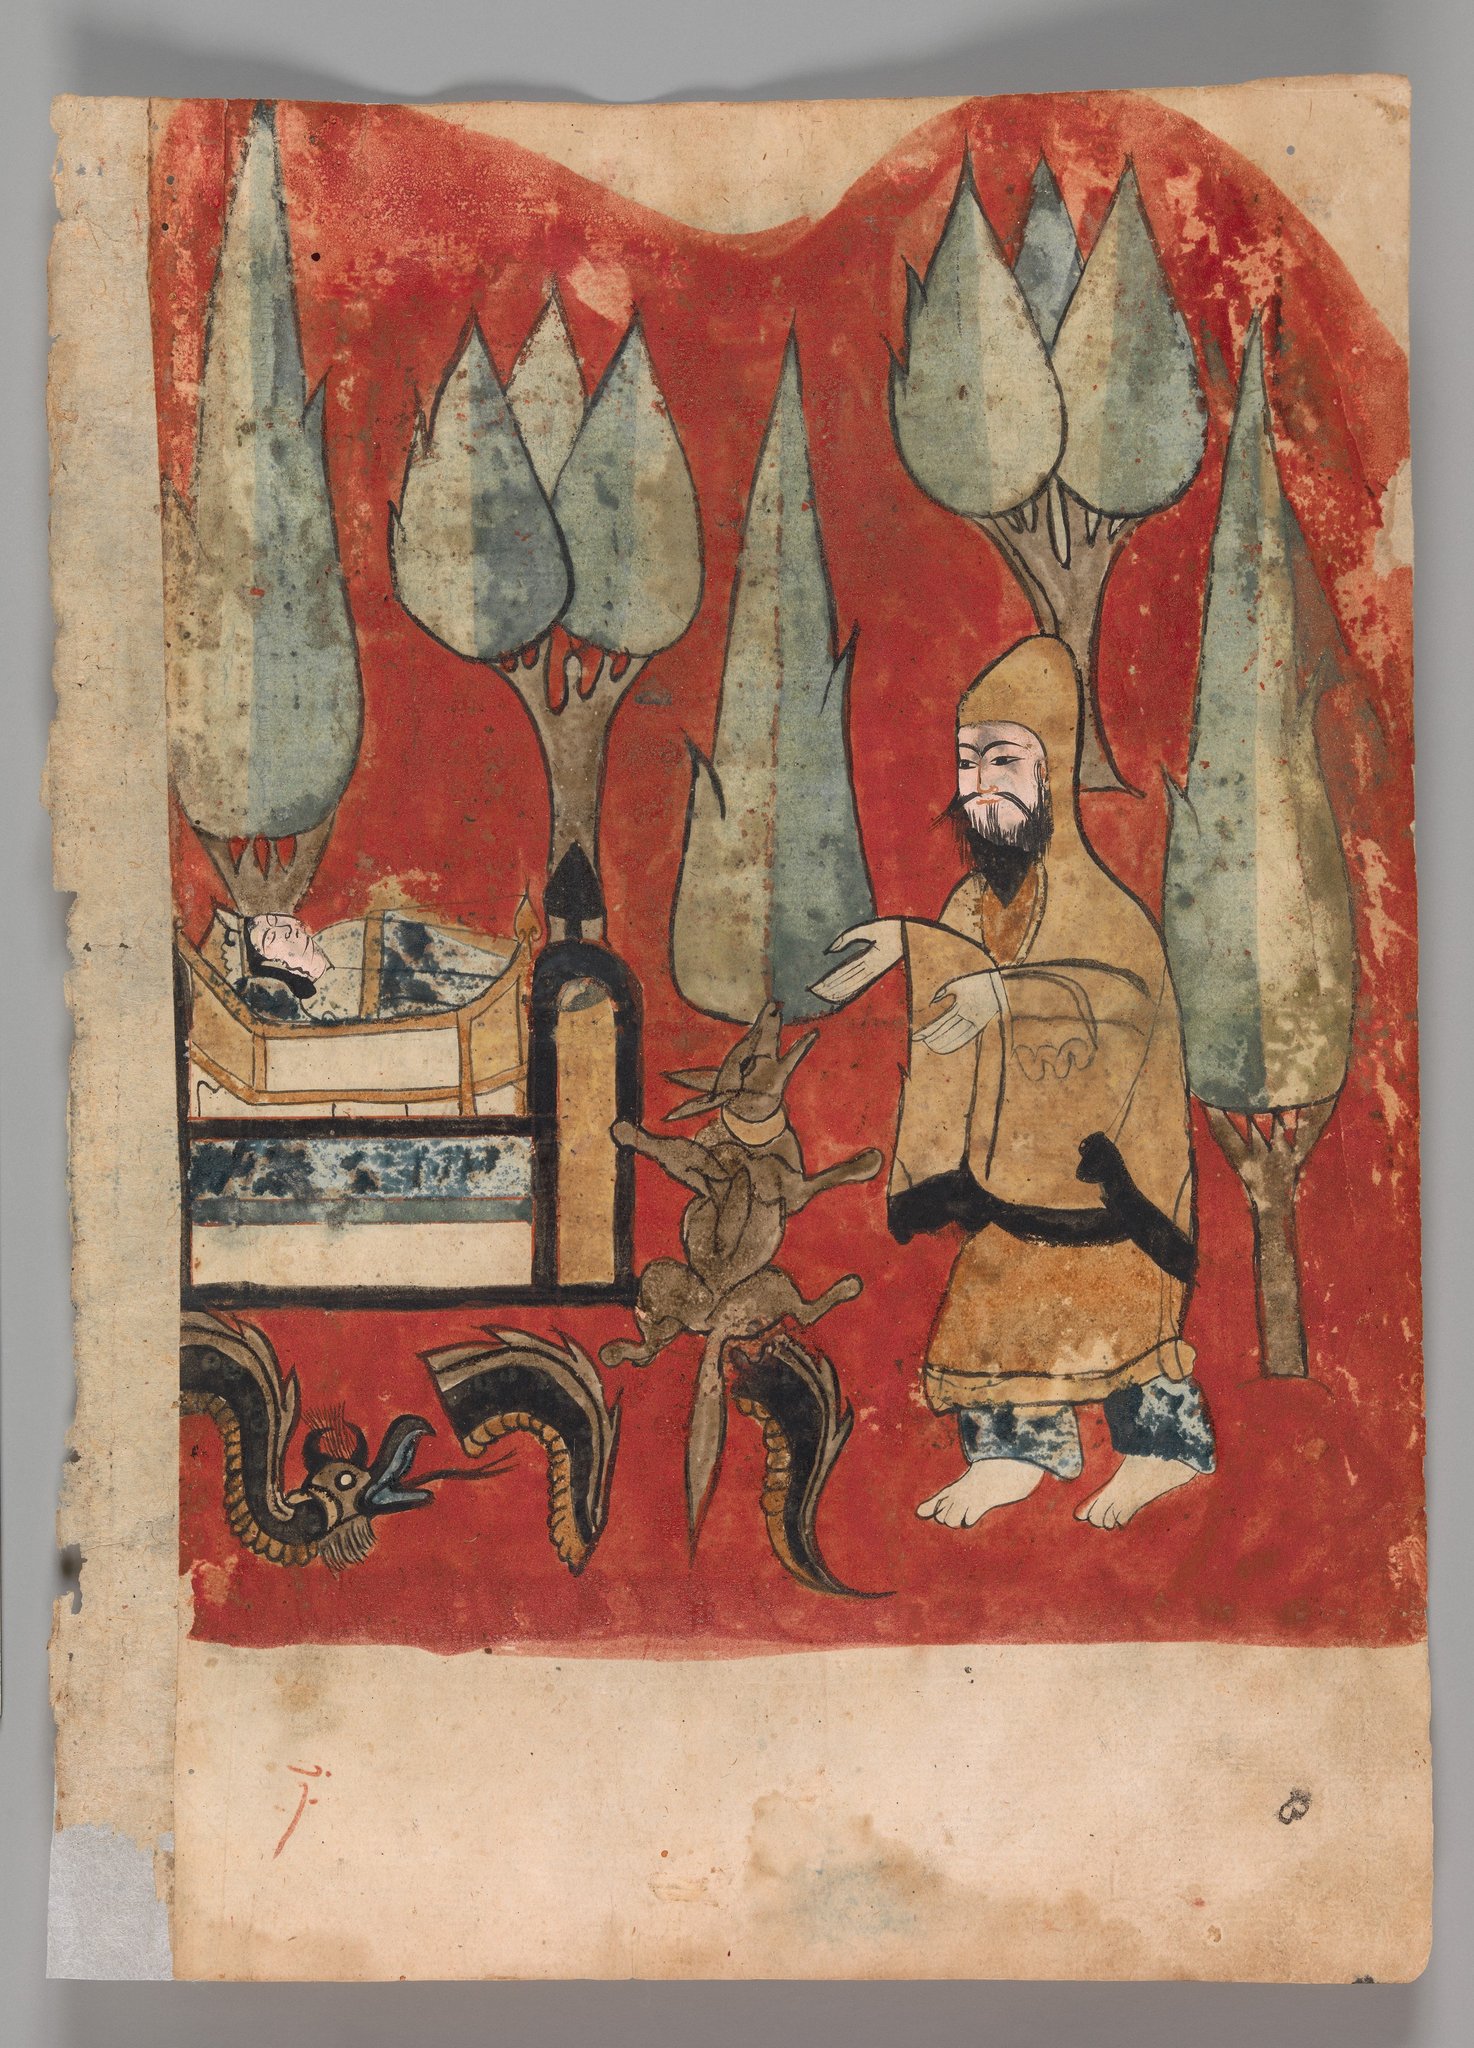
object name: folio from an illustrated manuscript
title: "The Ascetic Finds his Son Alive in his Crib", Folio from a Kalila wa Dimna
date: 1526-1550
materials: ink, paper, watercolor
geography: india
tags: animals,boys,men